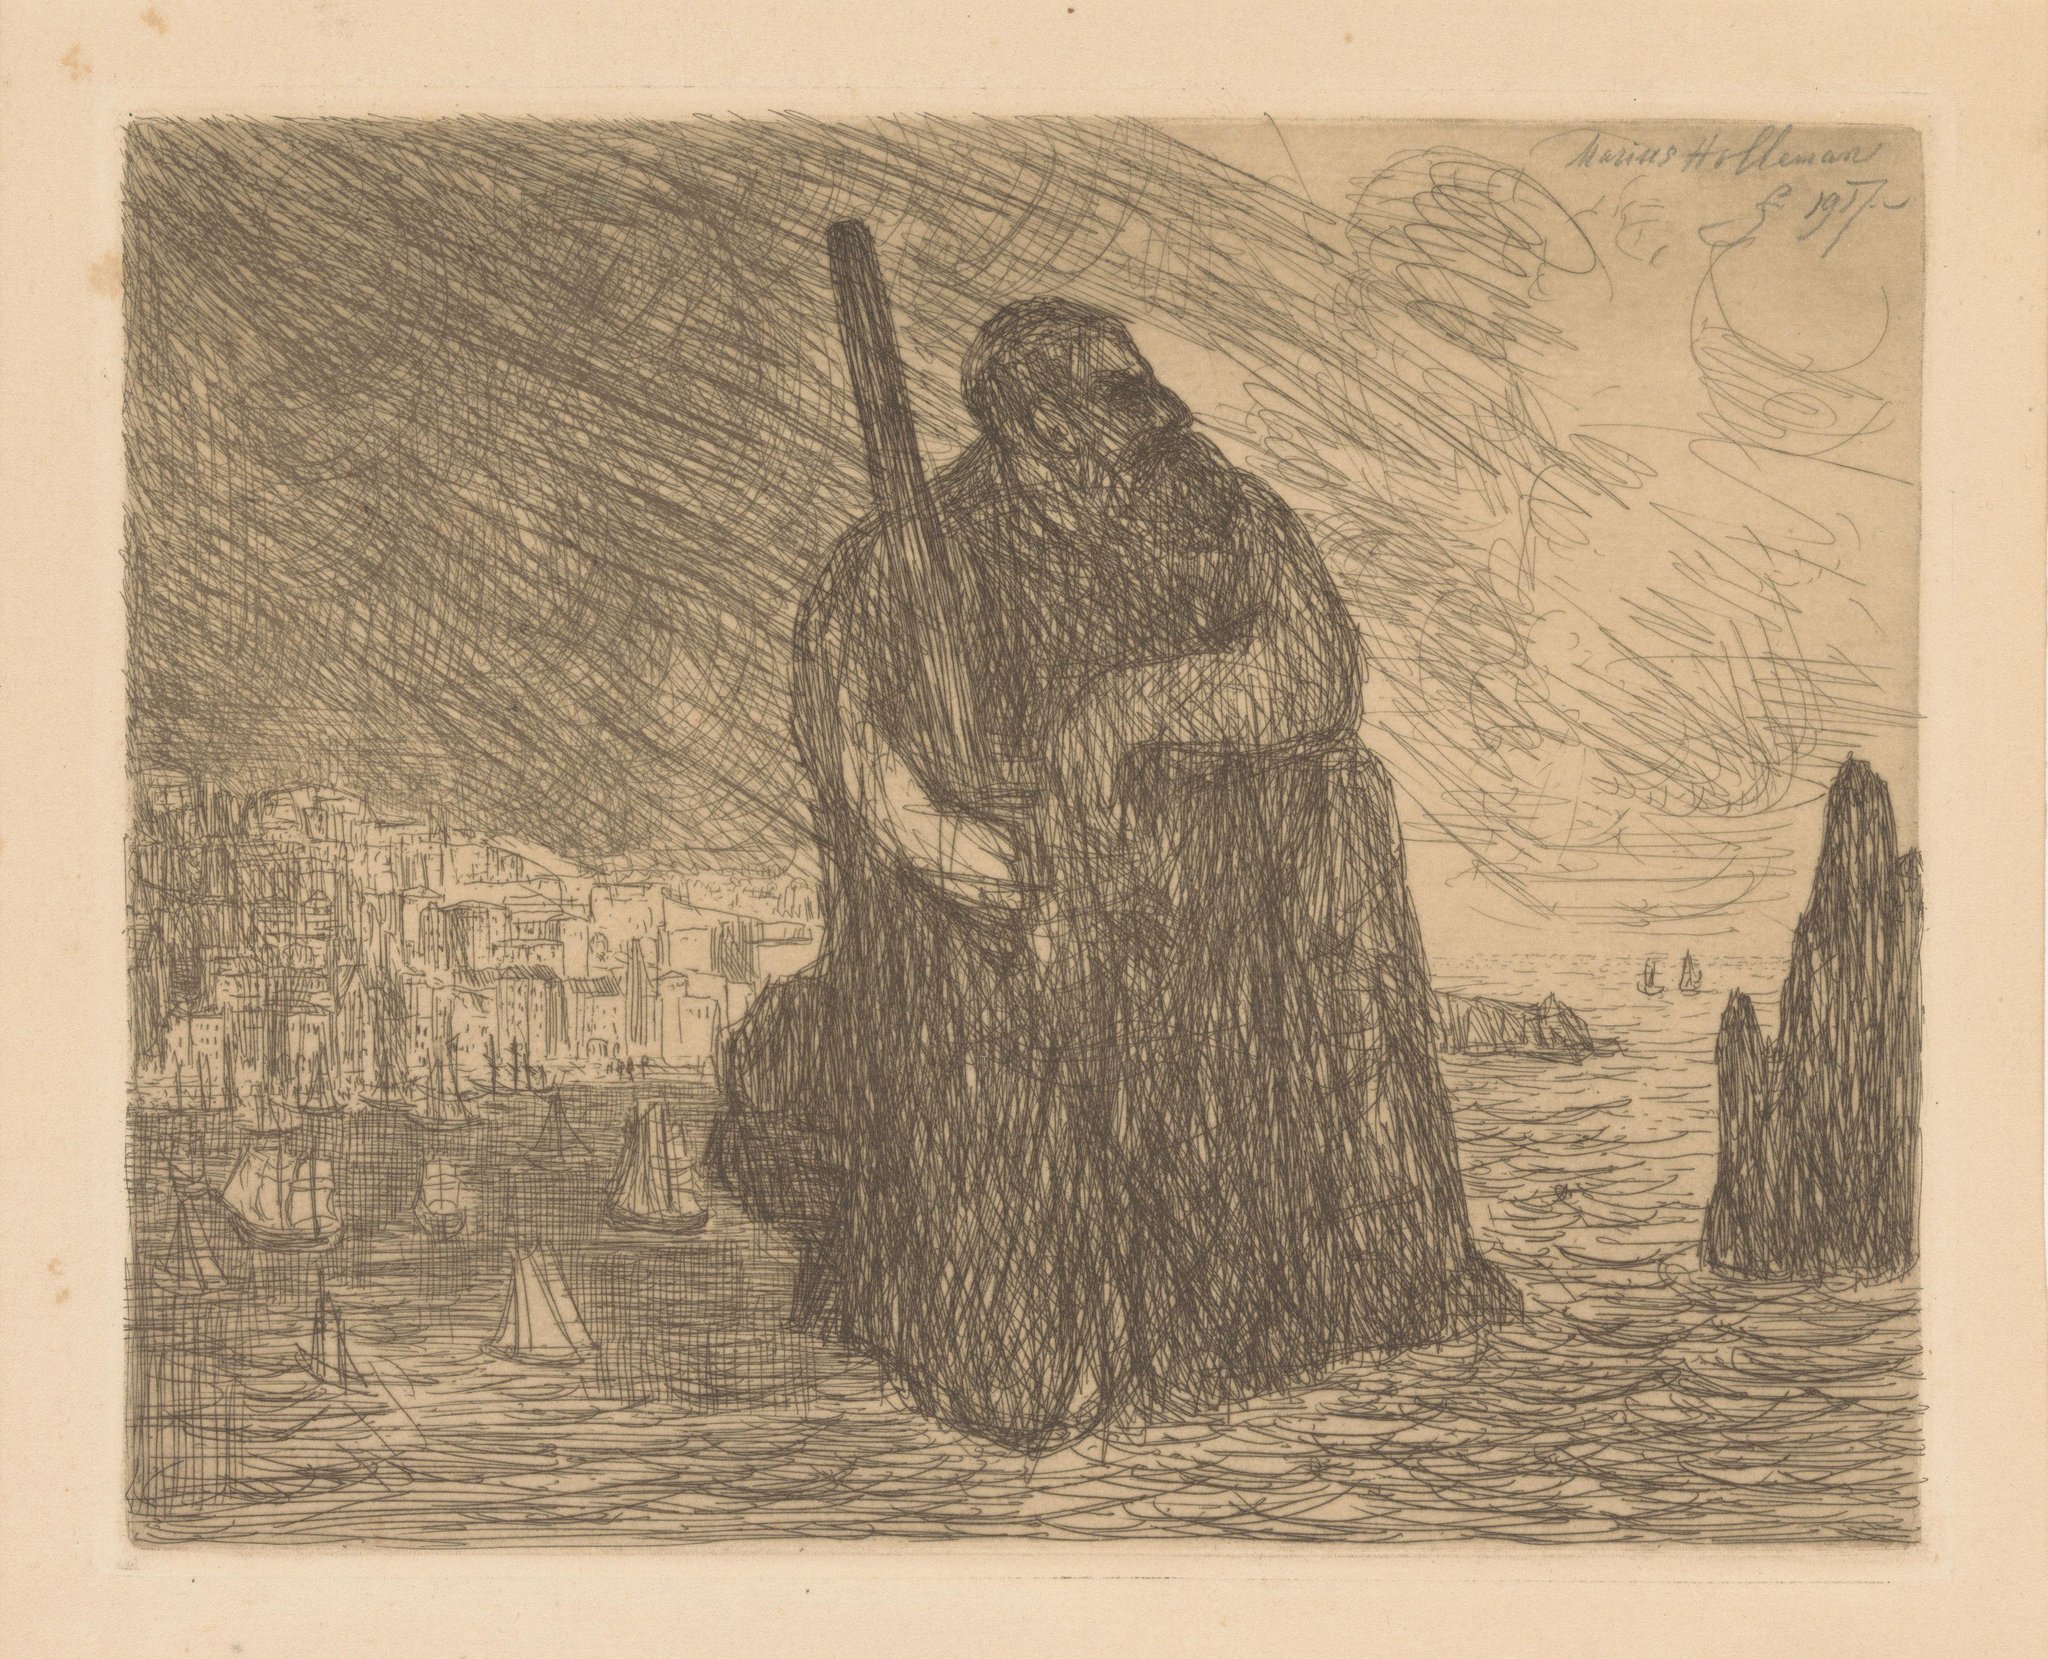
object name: print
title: Kolos van Rhodos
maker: marius holleman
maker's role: draughtsman, print maker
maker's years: 1878-1926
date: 1917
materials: paper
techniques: etching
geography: groningen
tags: harbour, colossus of rhodes (wonder of the world)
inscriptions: collector's mark: Lugt 2228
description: Links een haveningang. In het midden de Kolos van Rhodos, zittend en uitkijkend over de zee.